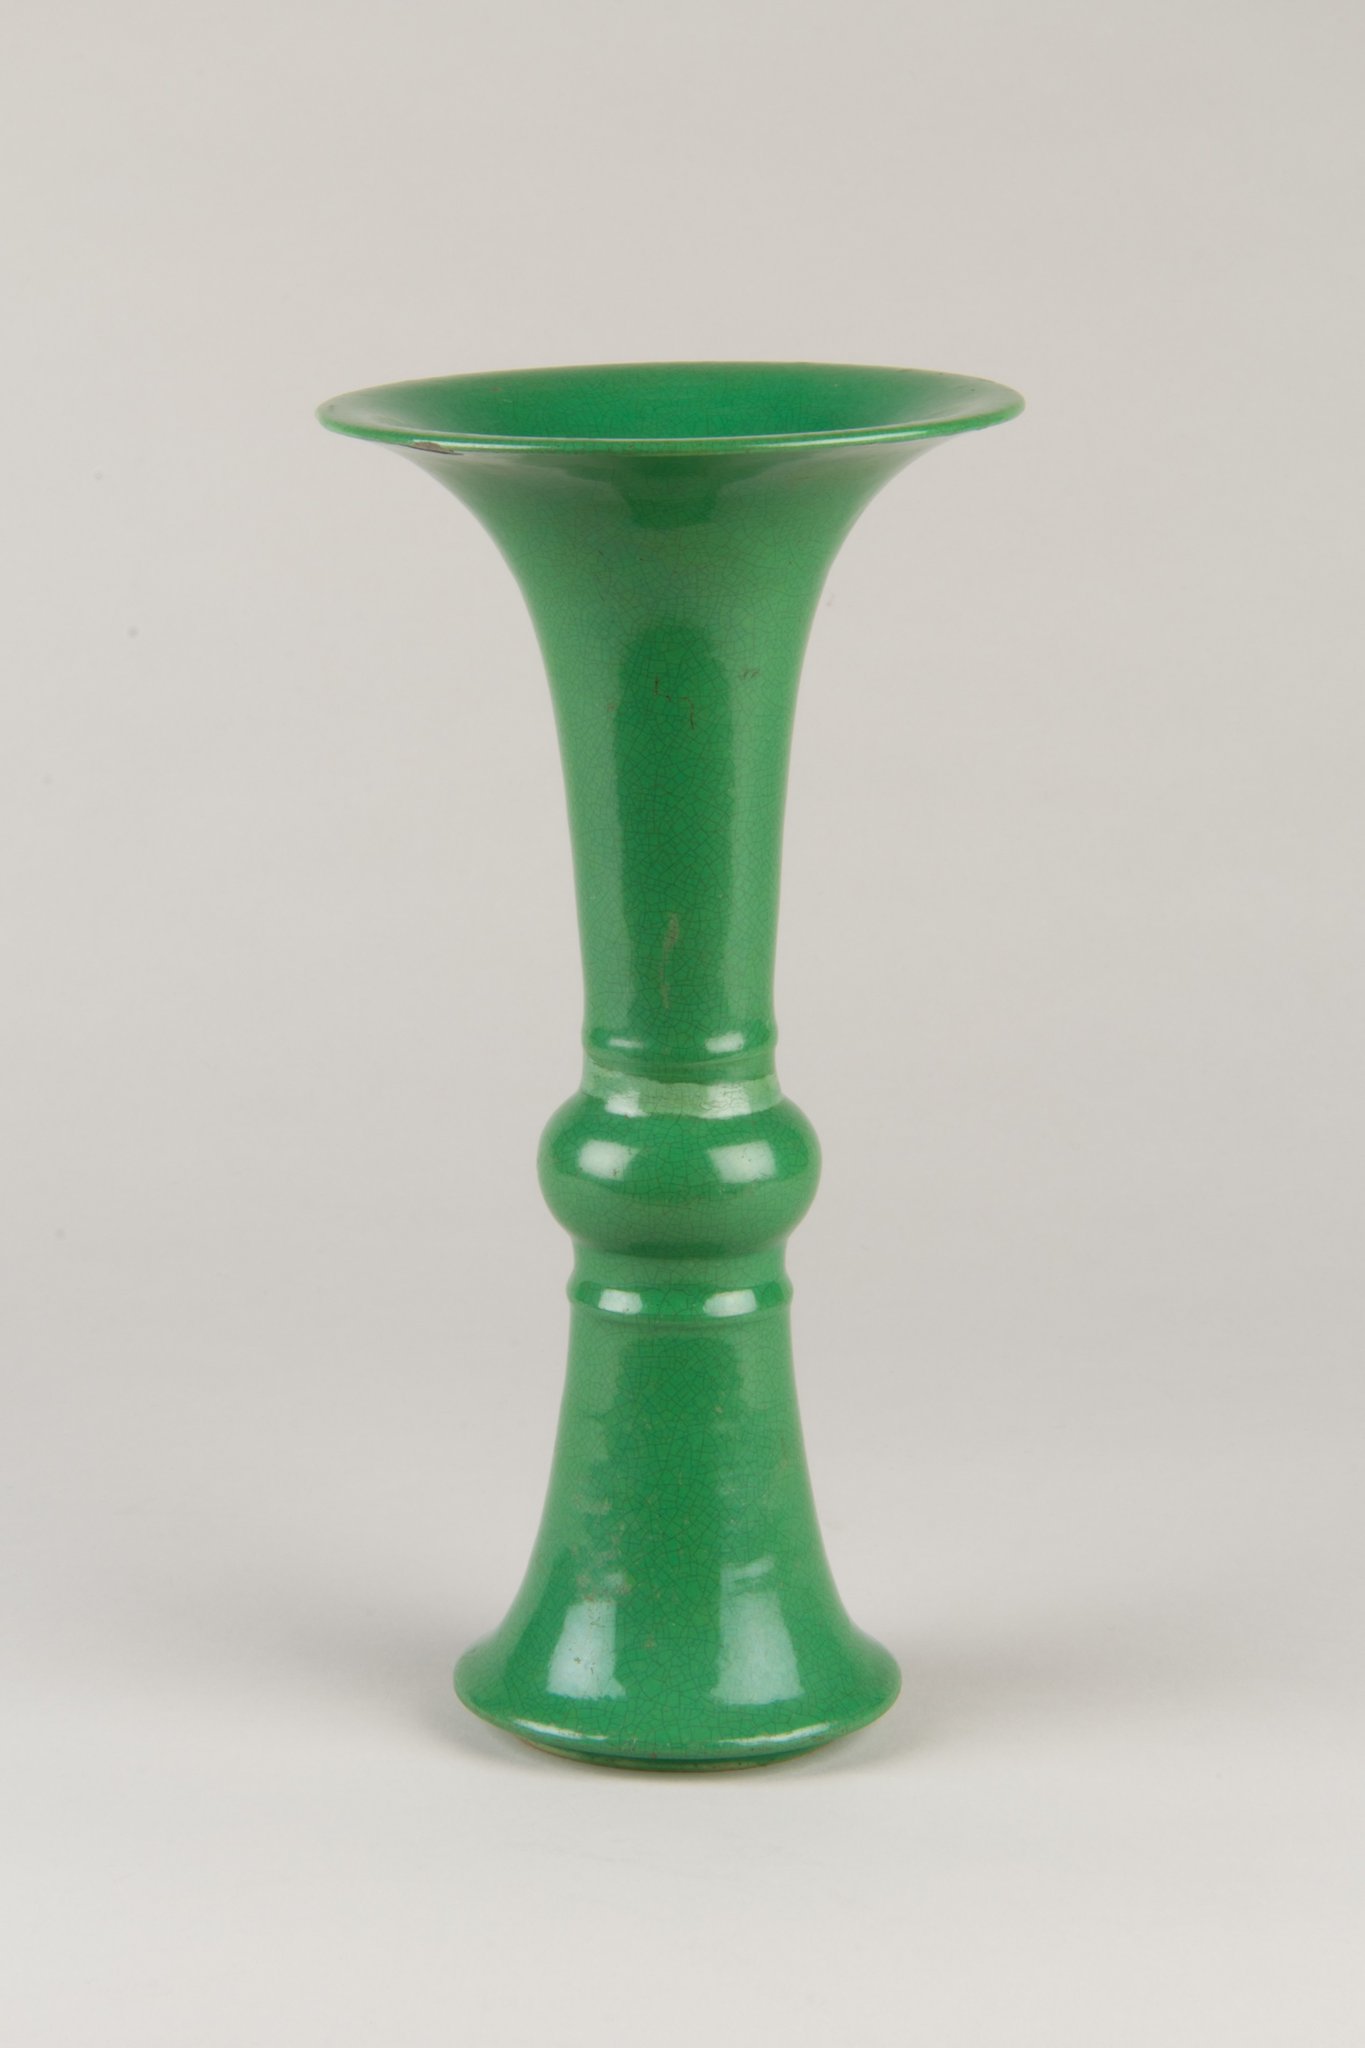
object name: vase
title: Vase in the shape of archaic wine container (gu)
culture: chinese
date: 1701-1800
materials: porcelain